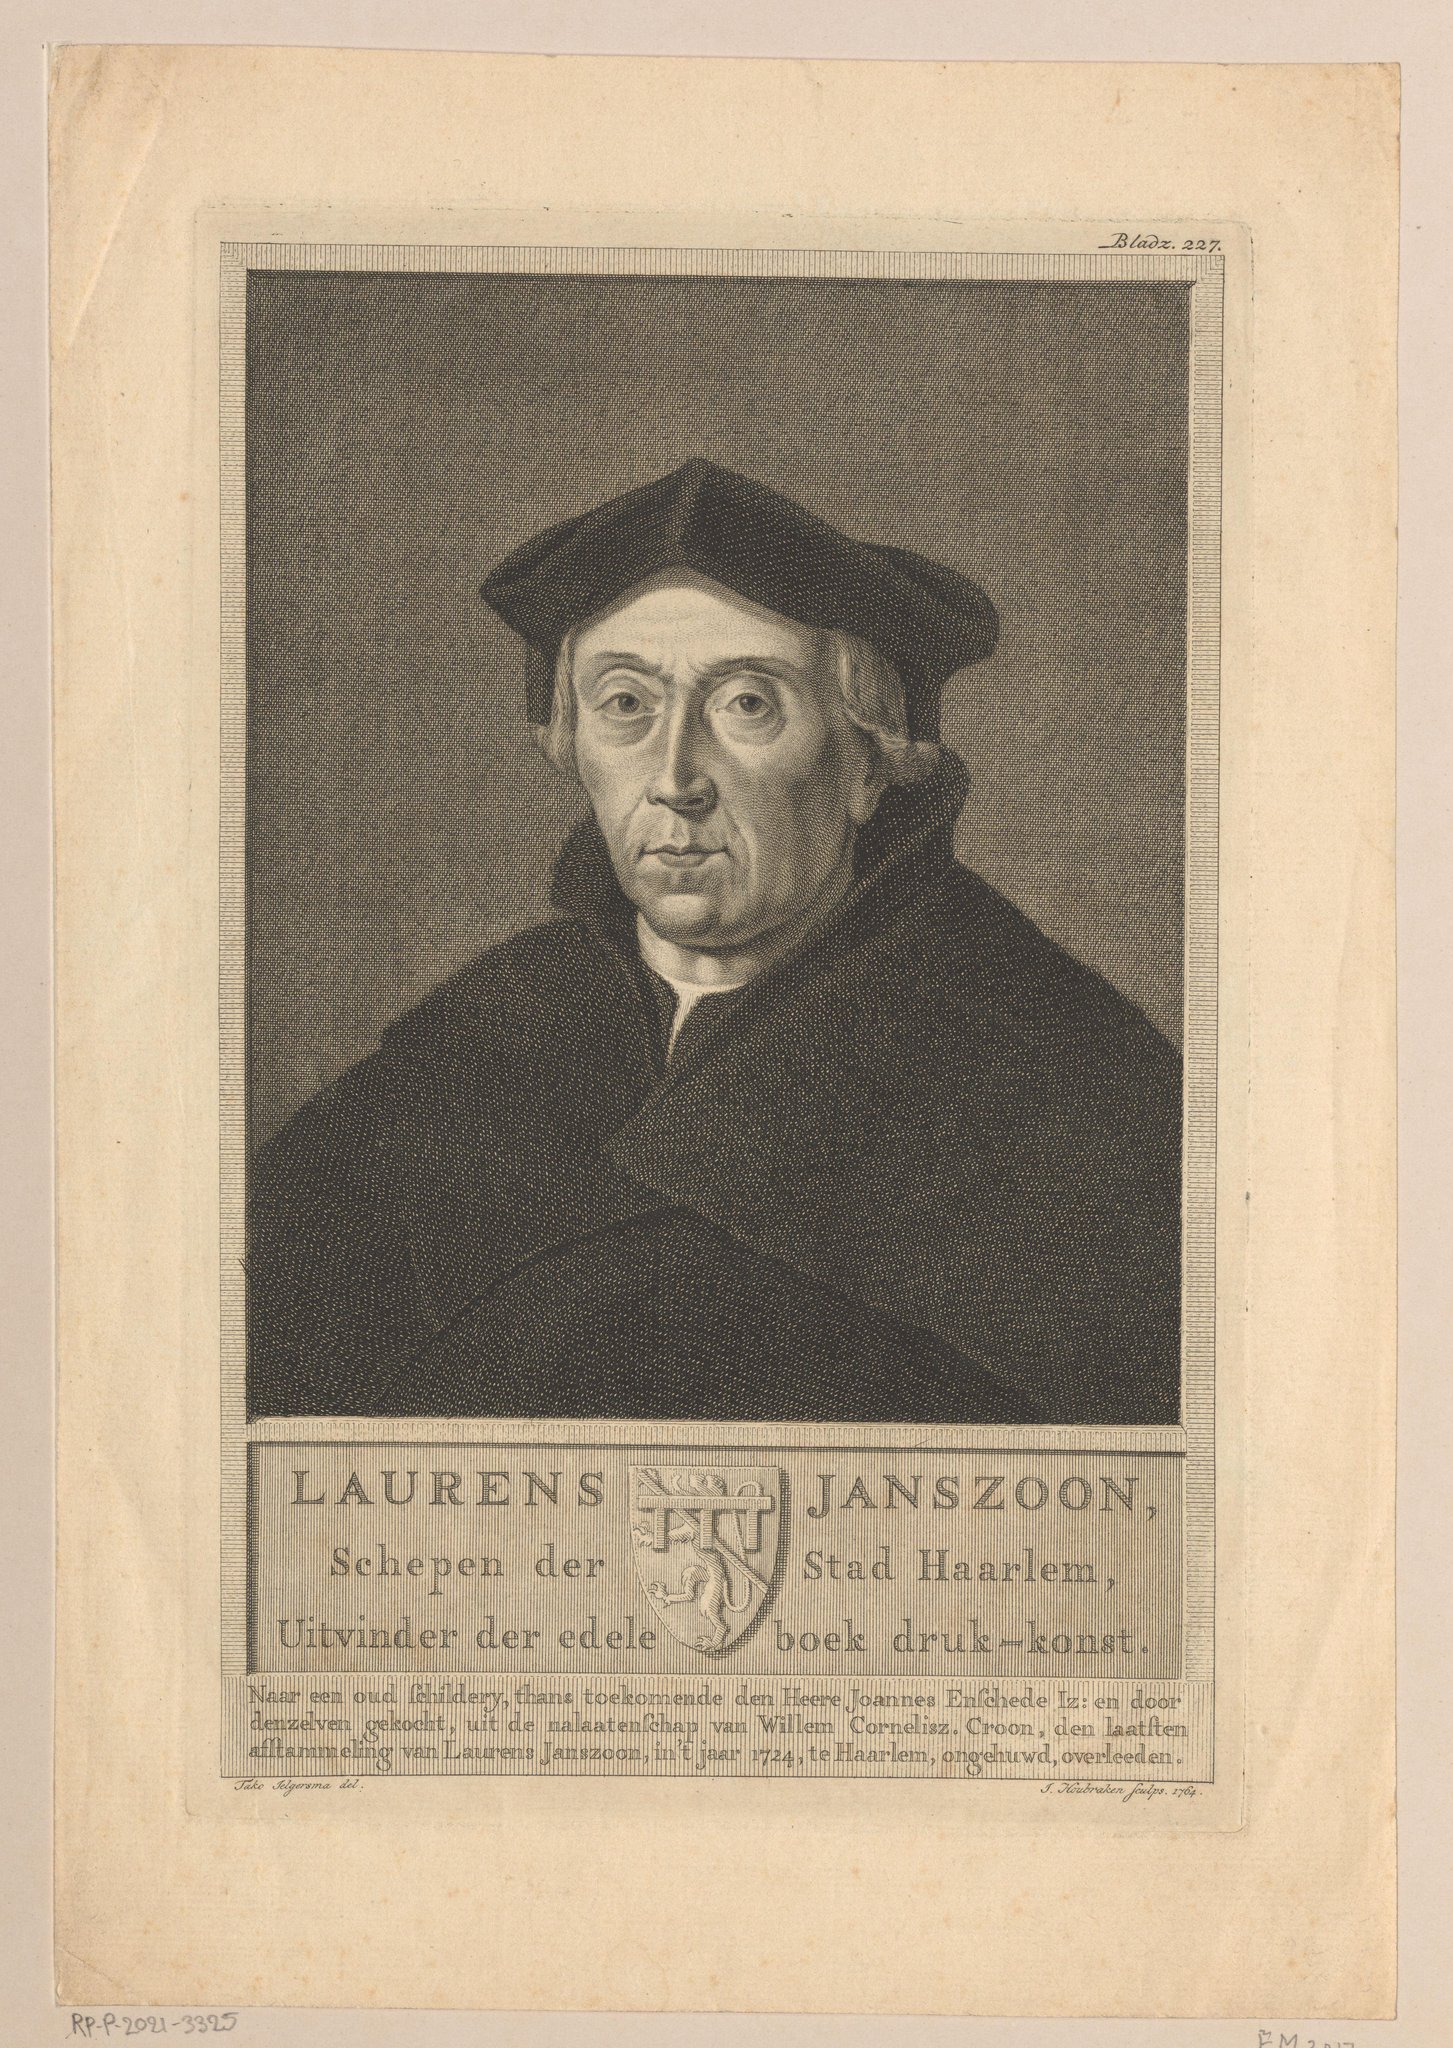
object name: print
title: Portret van Laurens Janszoon Coster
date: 1764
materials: paper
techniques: engraving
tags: historical persons, armorial bearing, heraldry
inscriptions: date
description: Rechtsboven genummerd: Bladz. 227. Onder het portret zijn wapenschild.